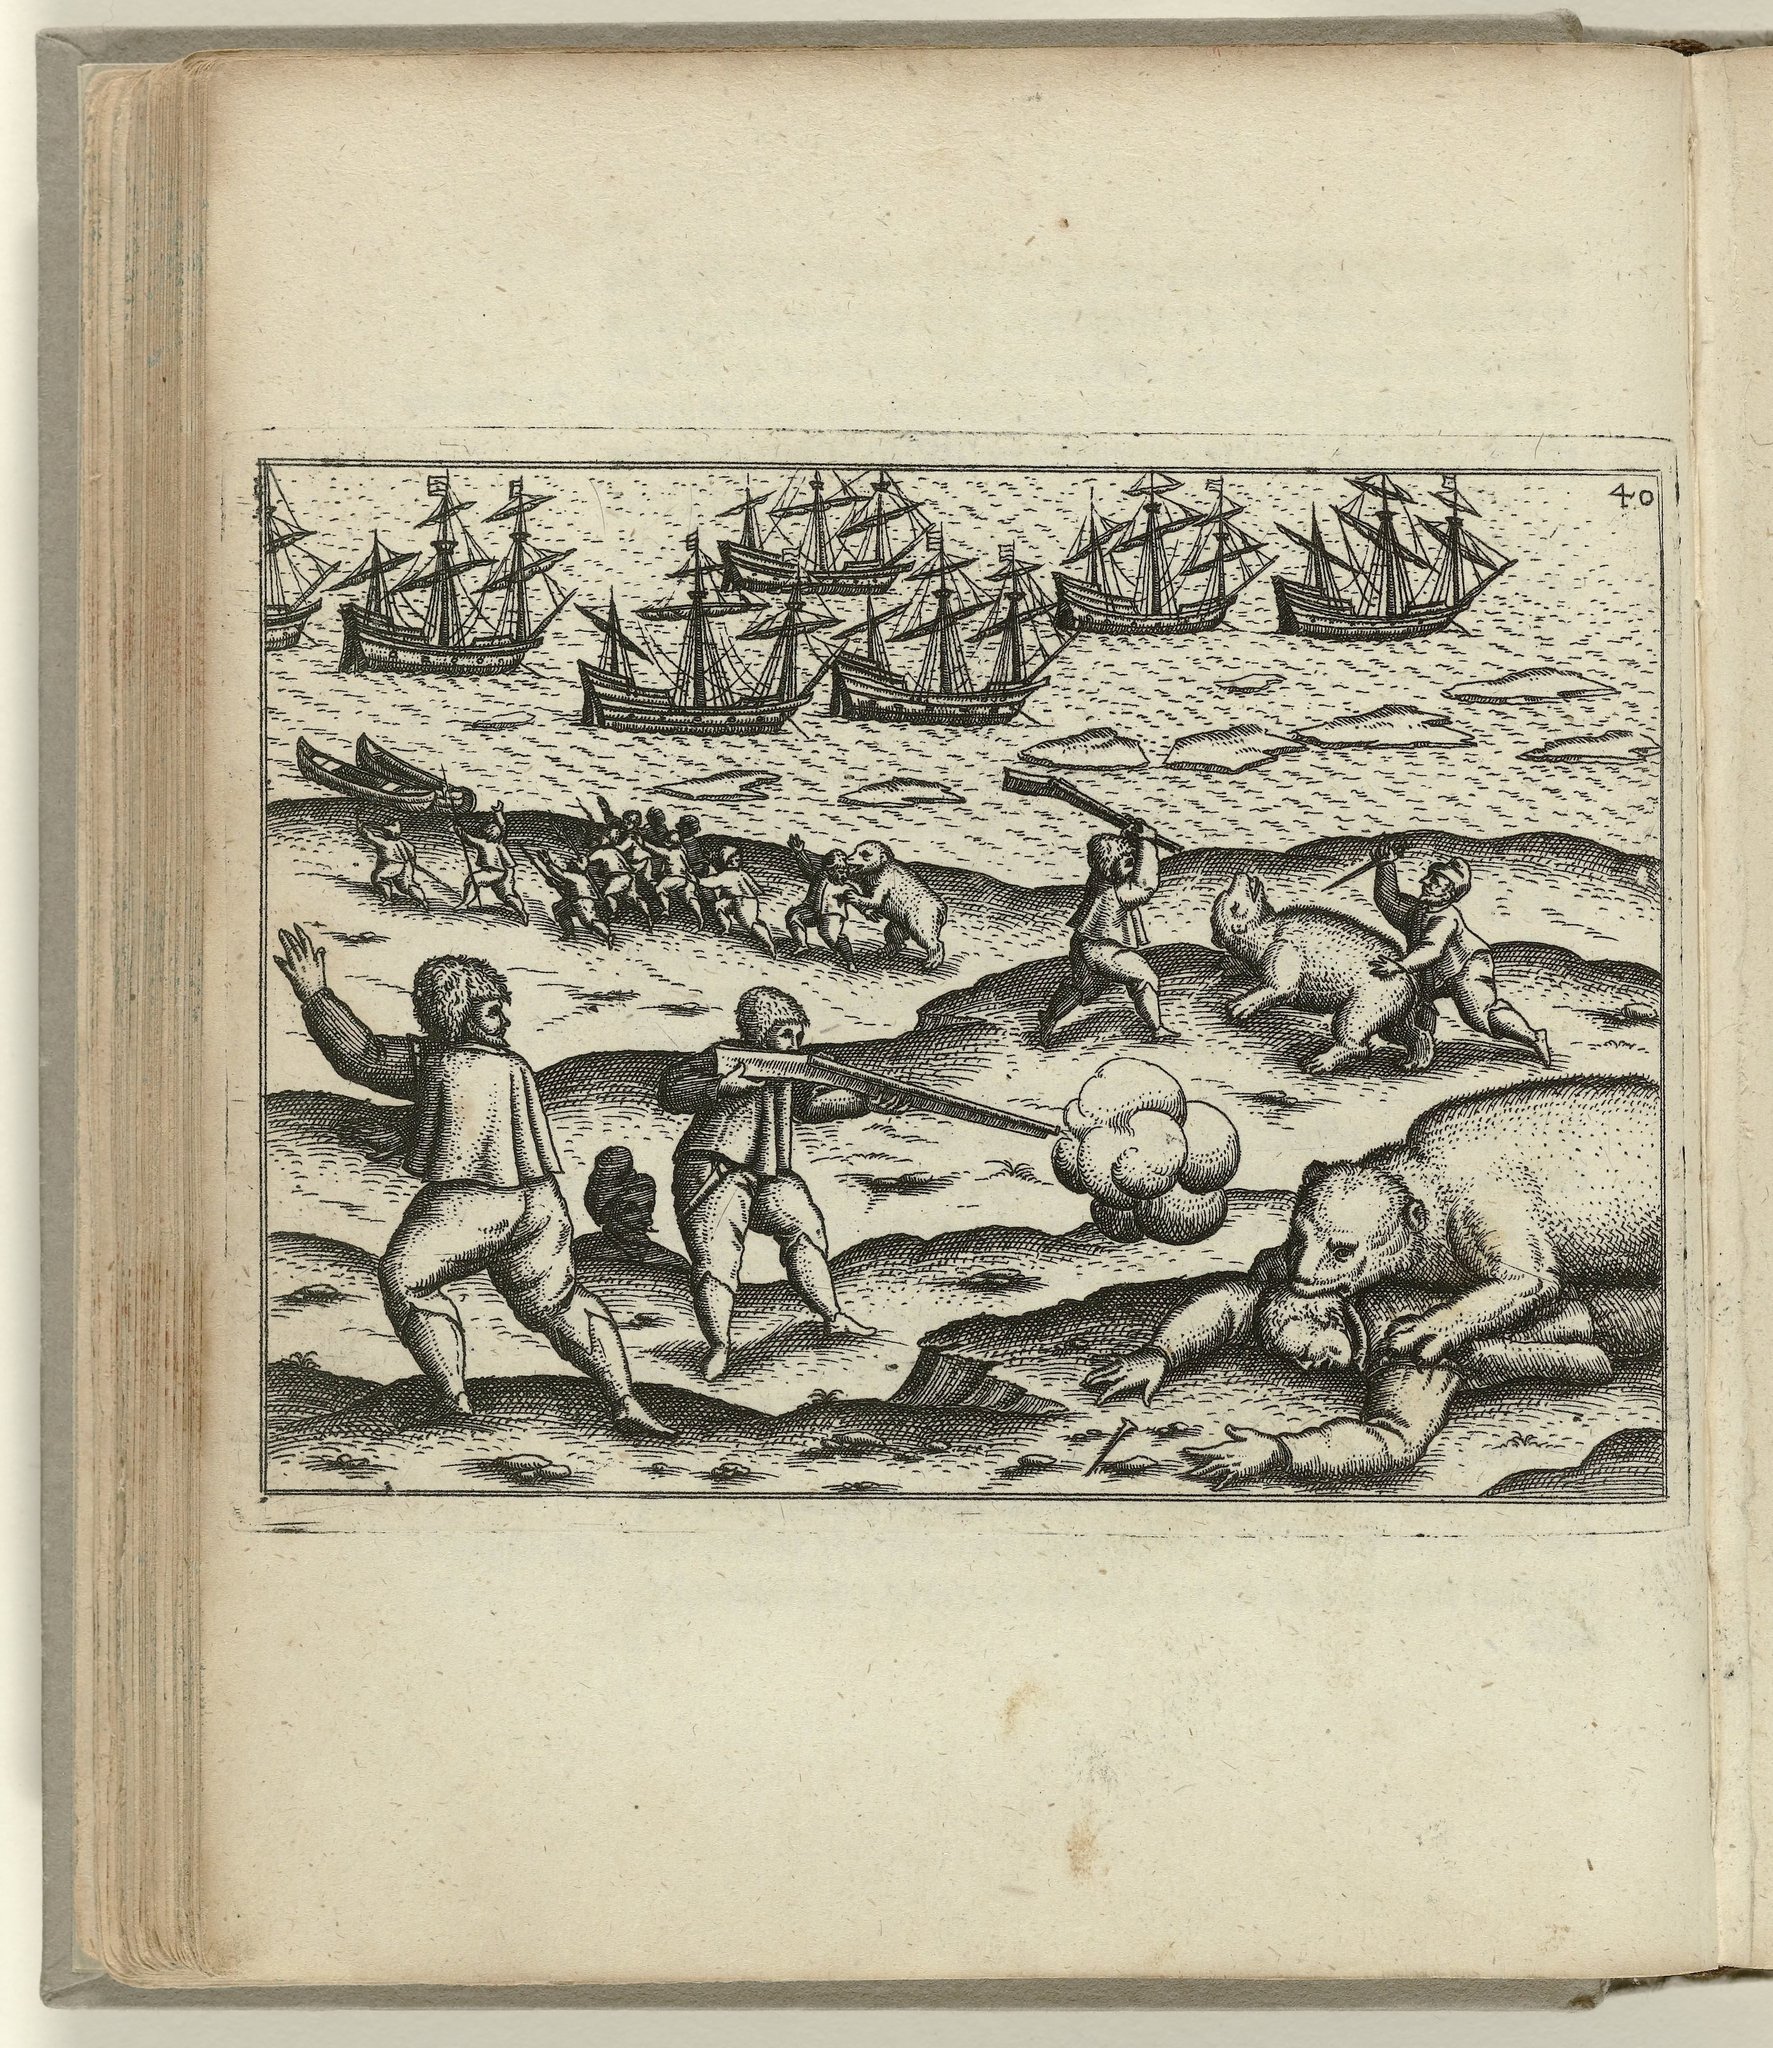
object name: print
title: Schieten van de ijsbeer die twee zeelieden had aangevallen, 1595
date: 1598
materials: paper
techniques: engraving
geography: nuremberg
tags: willem barendsz., amsterdam, jacob van heemskerck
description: Schieten van de ijsbeer die twee zeelieden had aangevallen, 6 september 1595. Op de achtergrond de schepen voor de kust. Tegenover pagina 40 in: 'Warhafftige Relation. Der dreyen newen unerhörten seltzamen Schiffart so die Holländischen und Seeländischen Schiff....Anno 1594, 1595 und 1596 verricht' (1598).